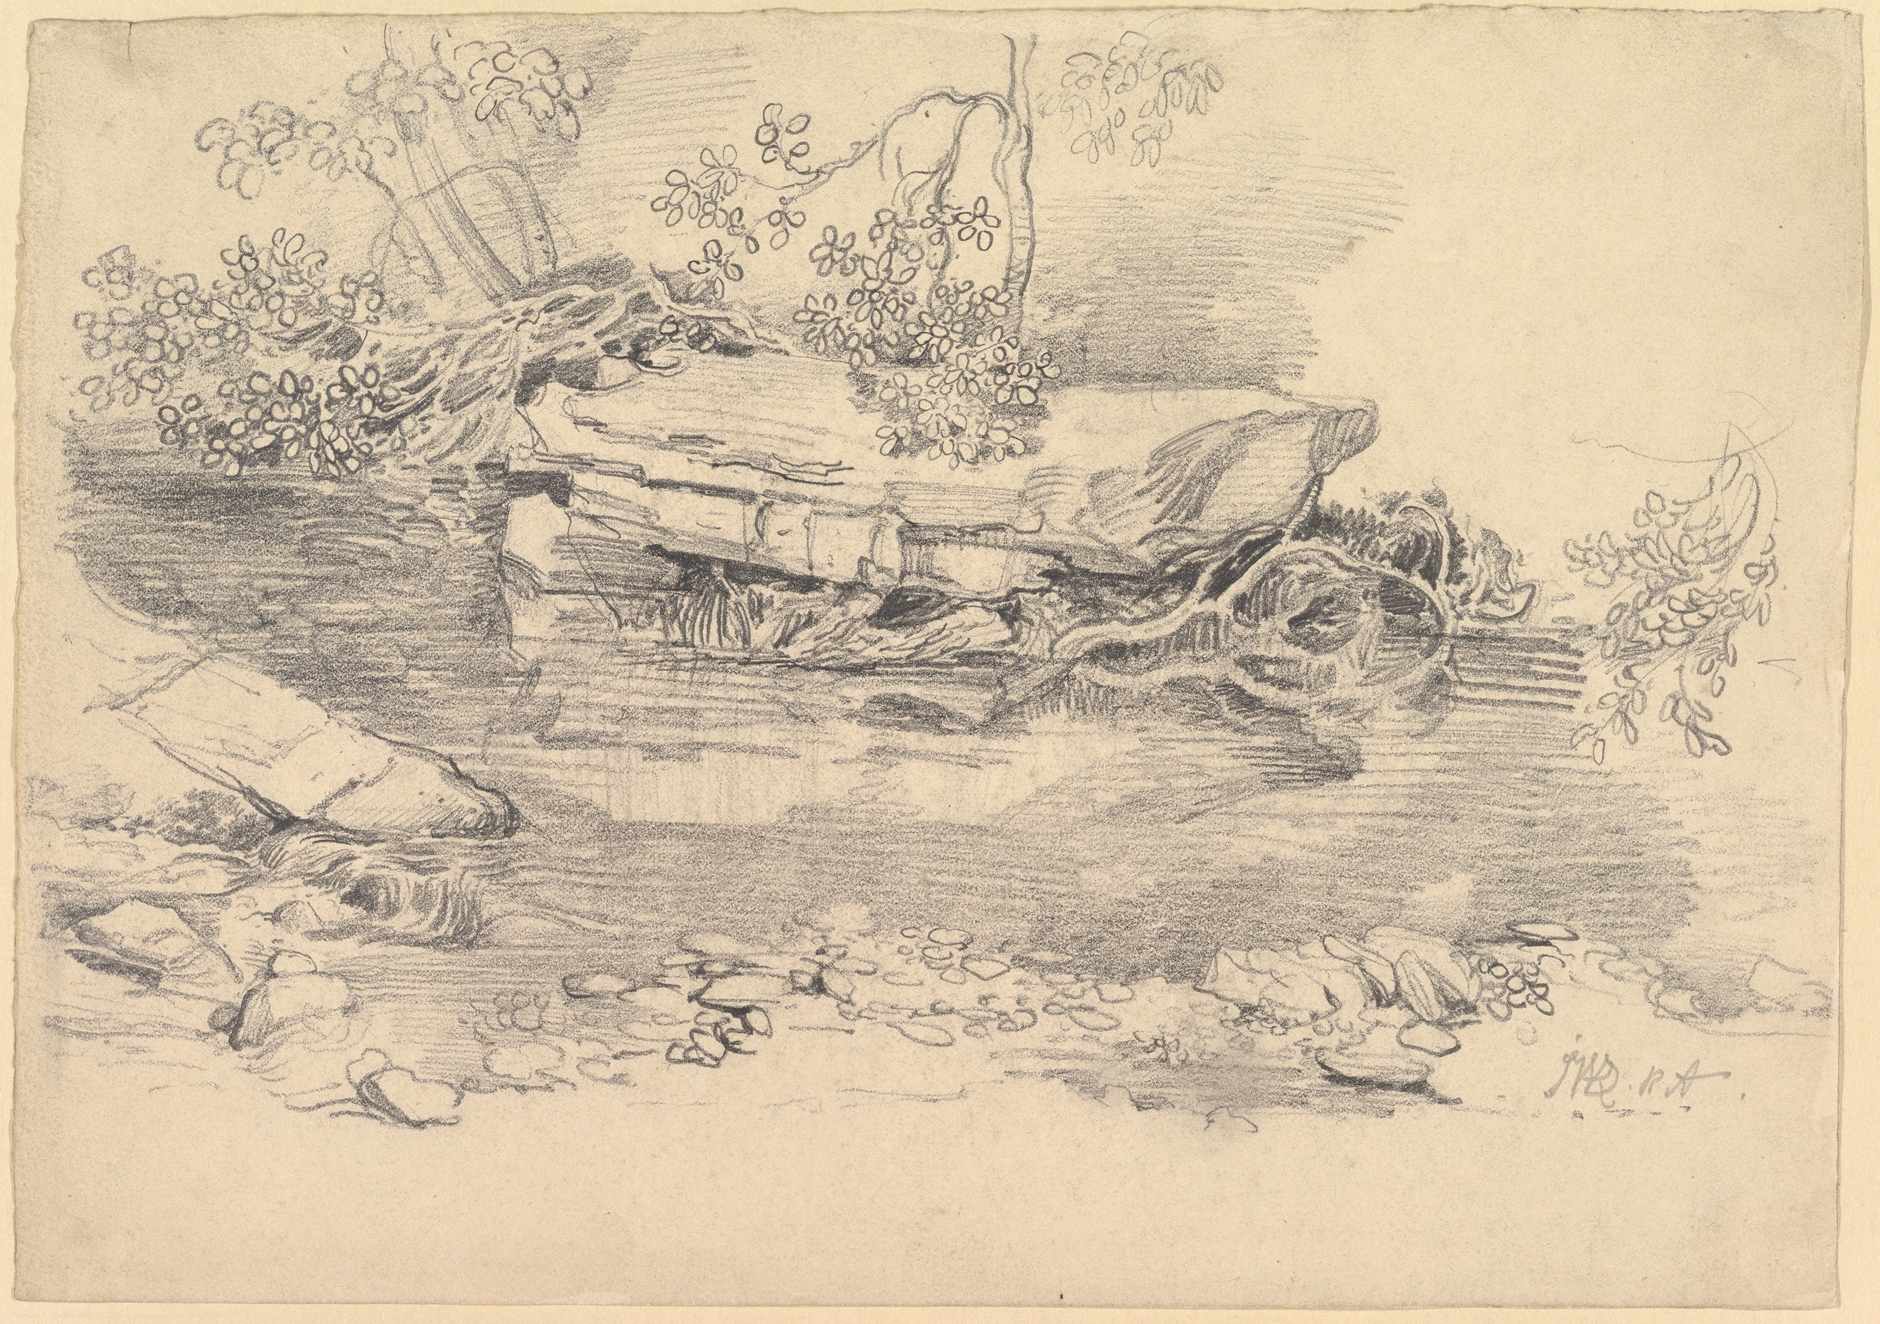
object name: drawing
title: A Rocky Stream or River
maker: james ward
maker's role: artist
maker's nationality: british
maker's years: 1769-1859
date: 1811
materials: graphite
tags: trees